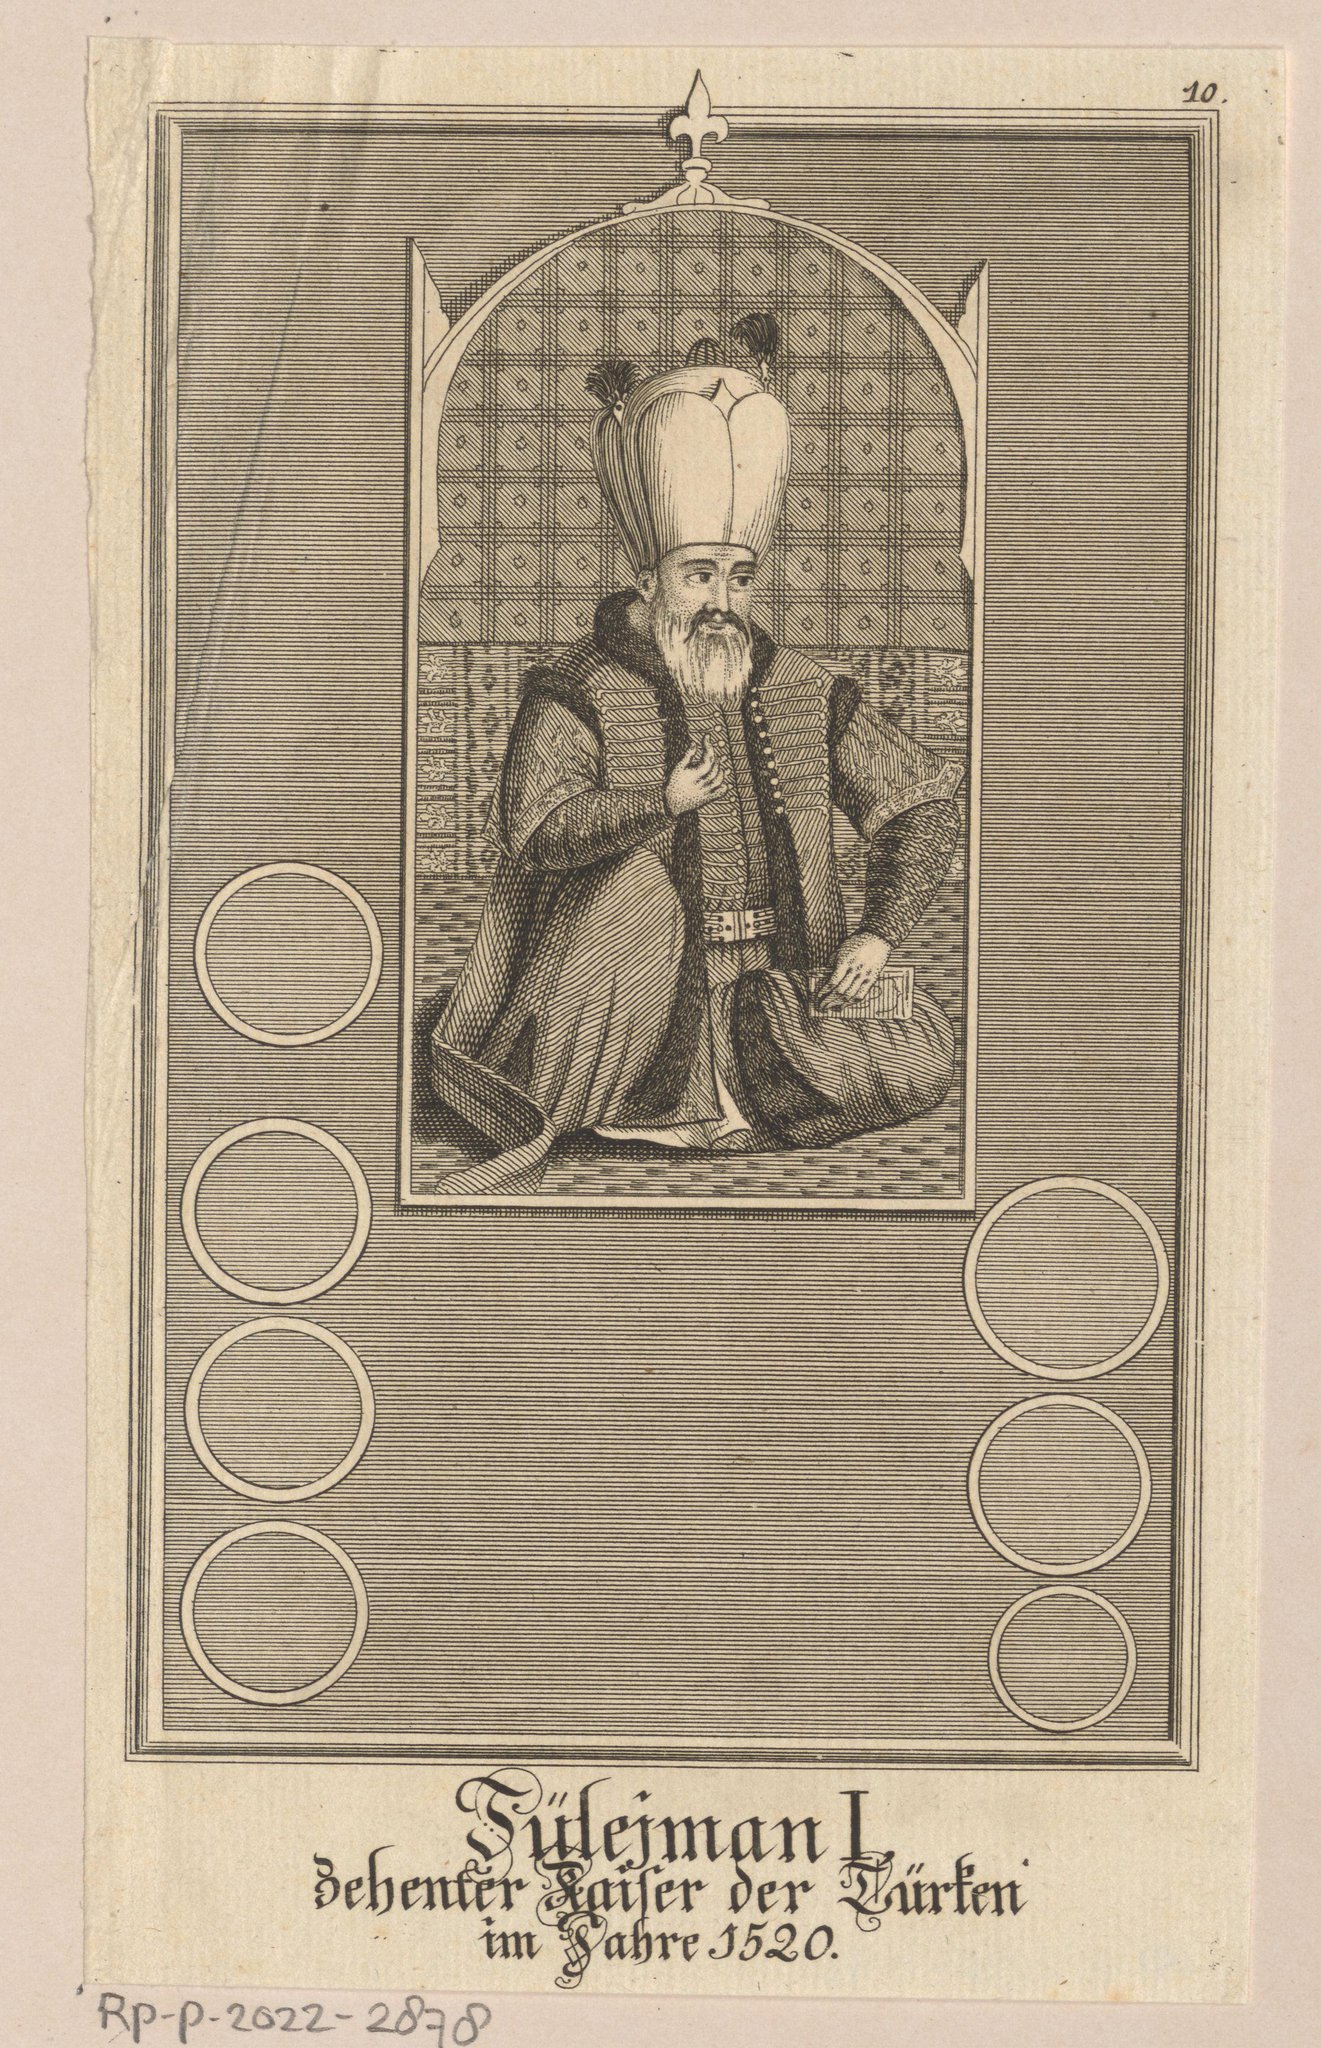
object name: print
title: Portret van Süleyman I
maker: Anonymous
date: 1700-1799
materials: paper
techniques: etching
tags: historical persons, other sovereign (with title)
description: Met drieregelig onderschrift in het Duits. Genummerd rechtsboven: 10.